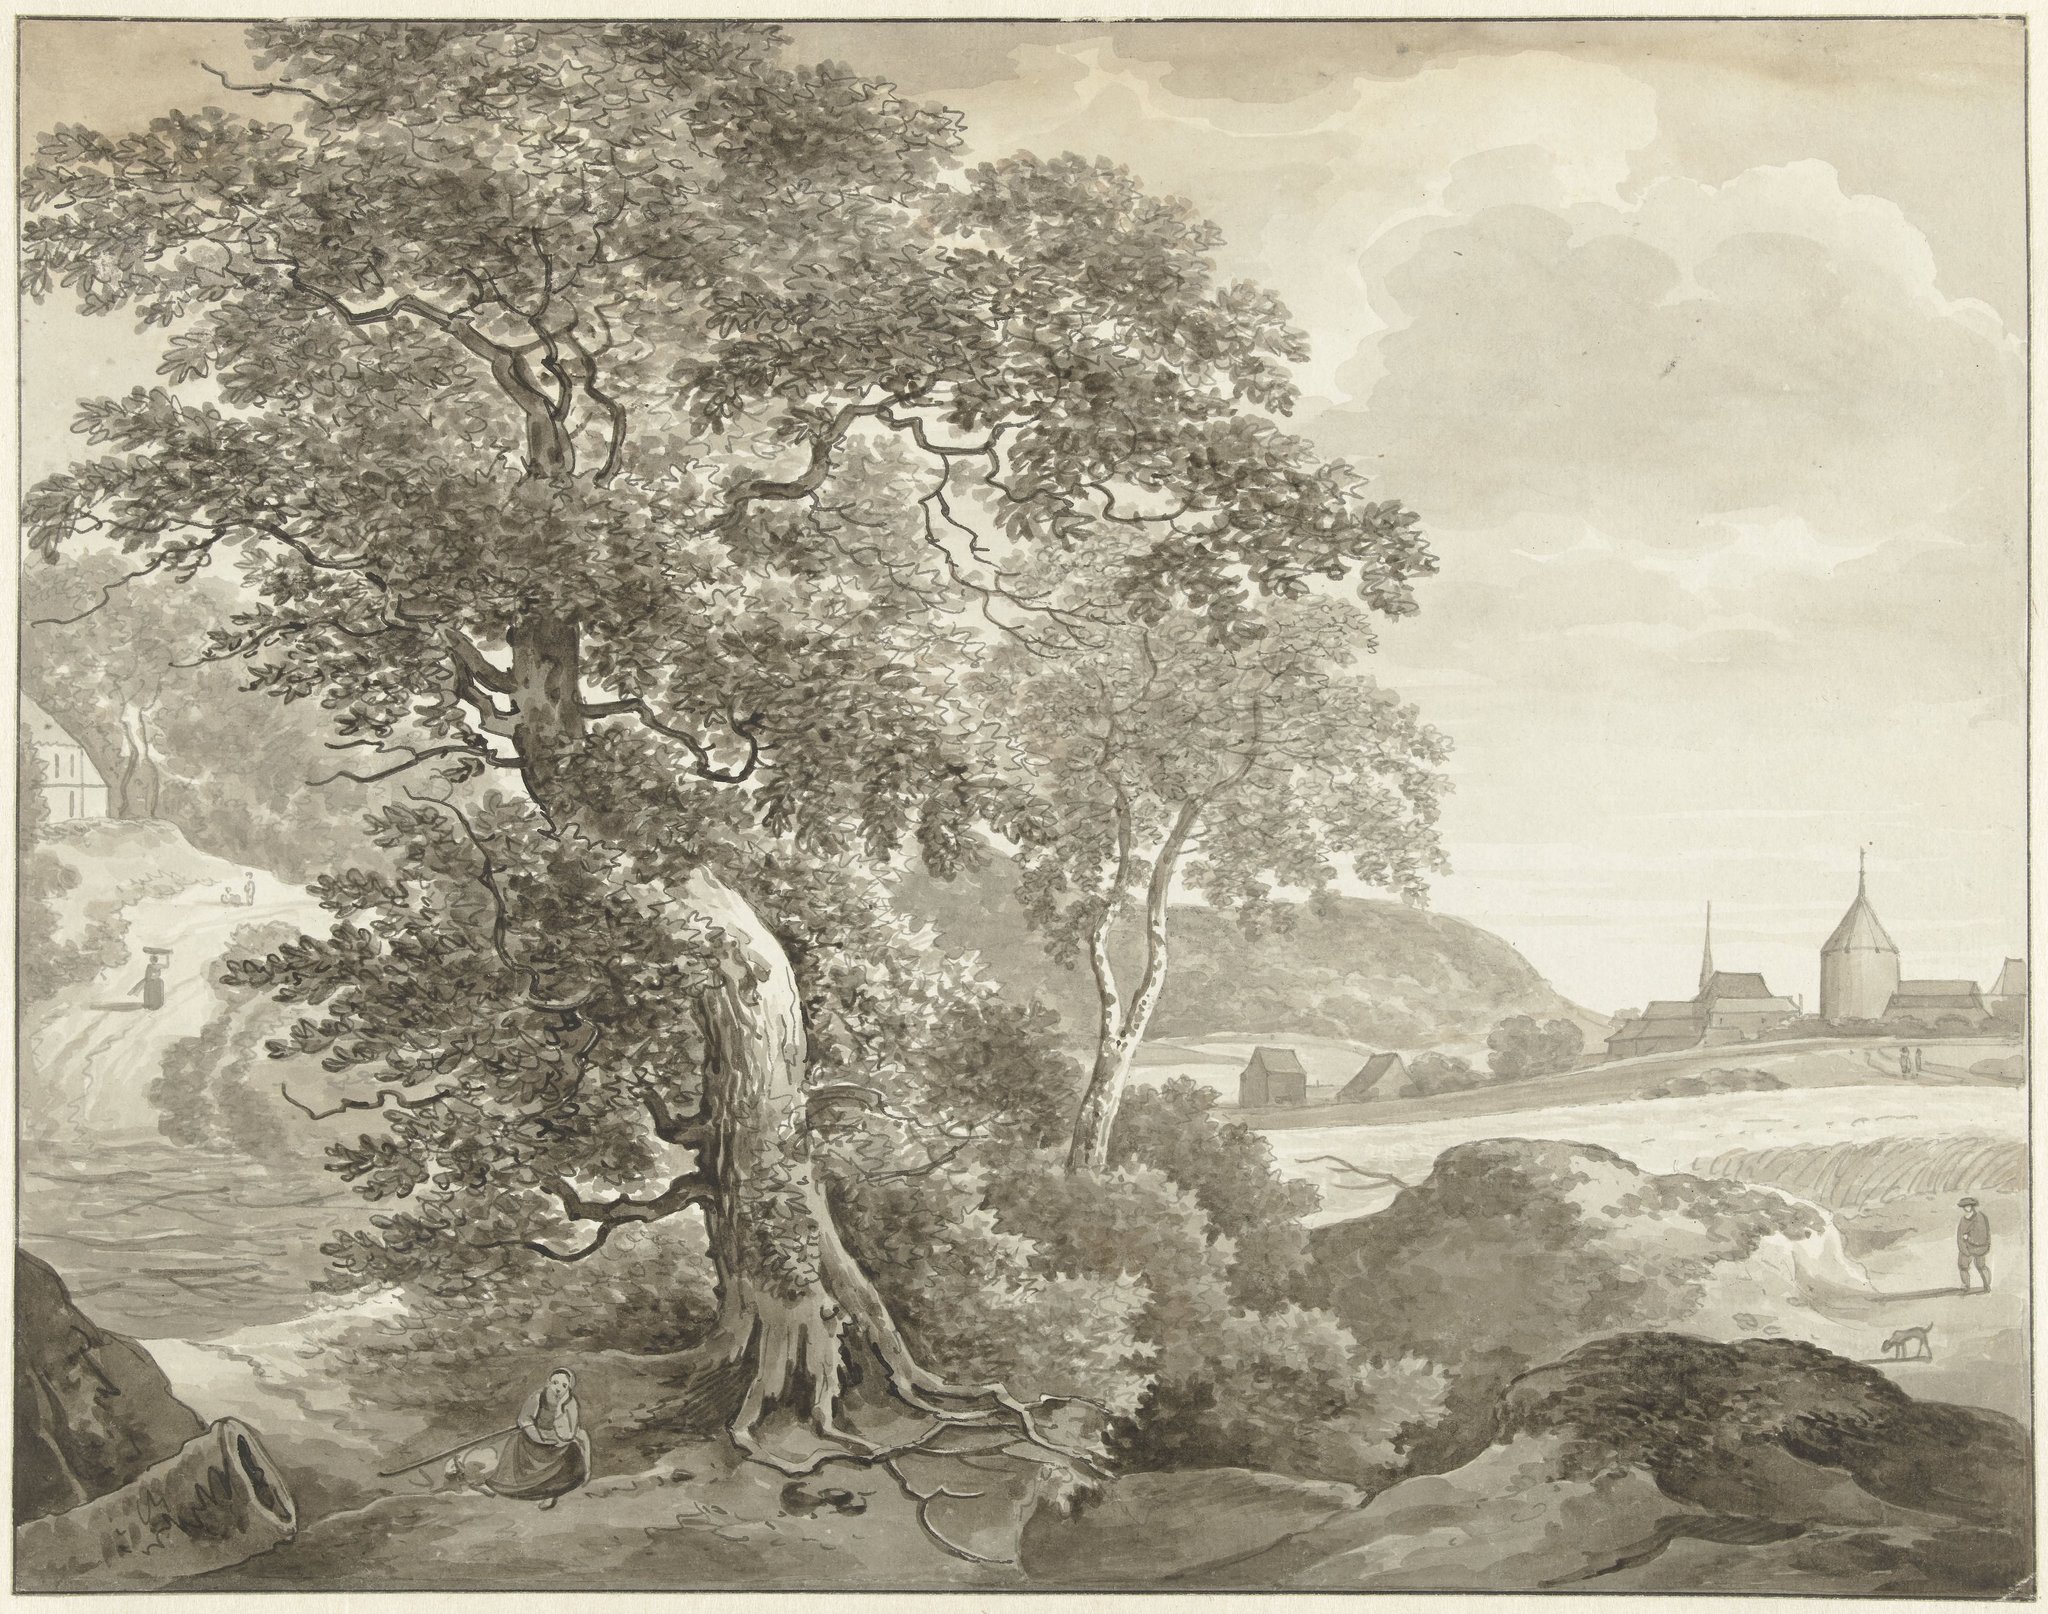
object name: drawing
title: Landschap naar Ruisdael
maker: daniël dupré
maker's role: draughtsman, print maker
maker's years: 1751-1817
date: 1786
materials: ink, paper, pencil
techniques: brush, pen